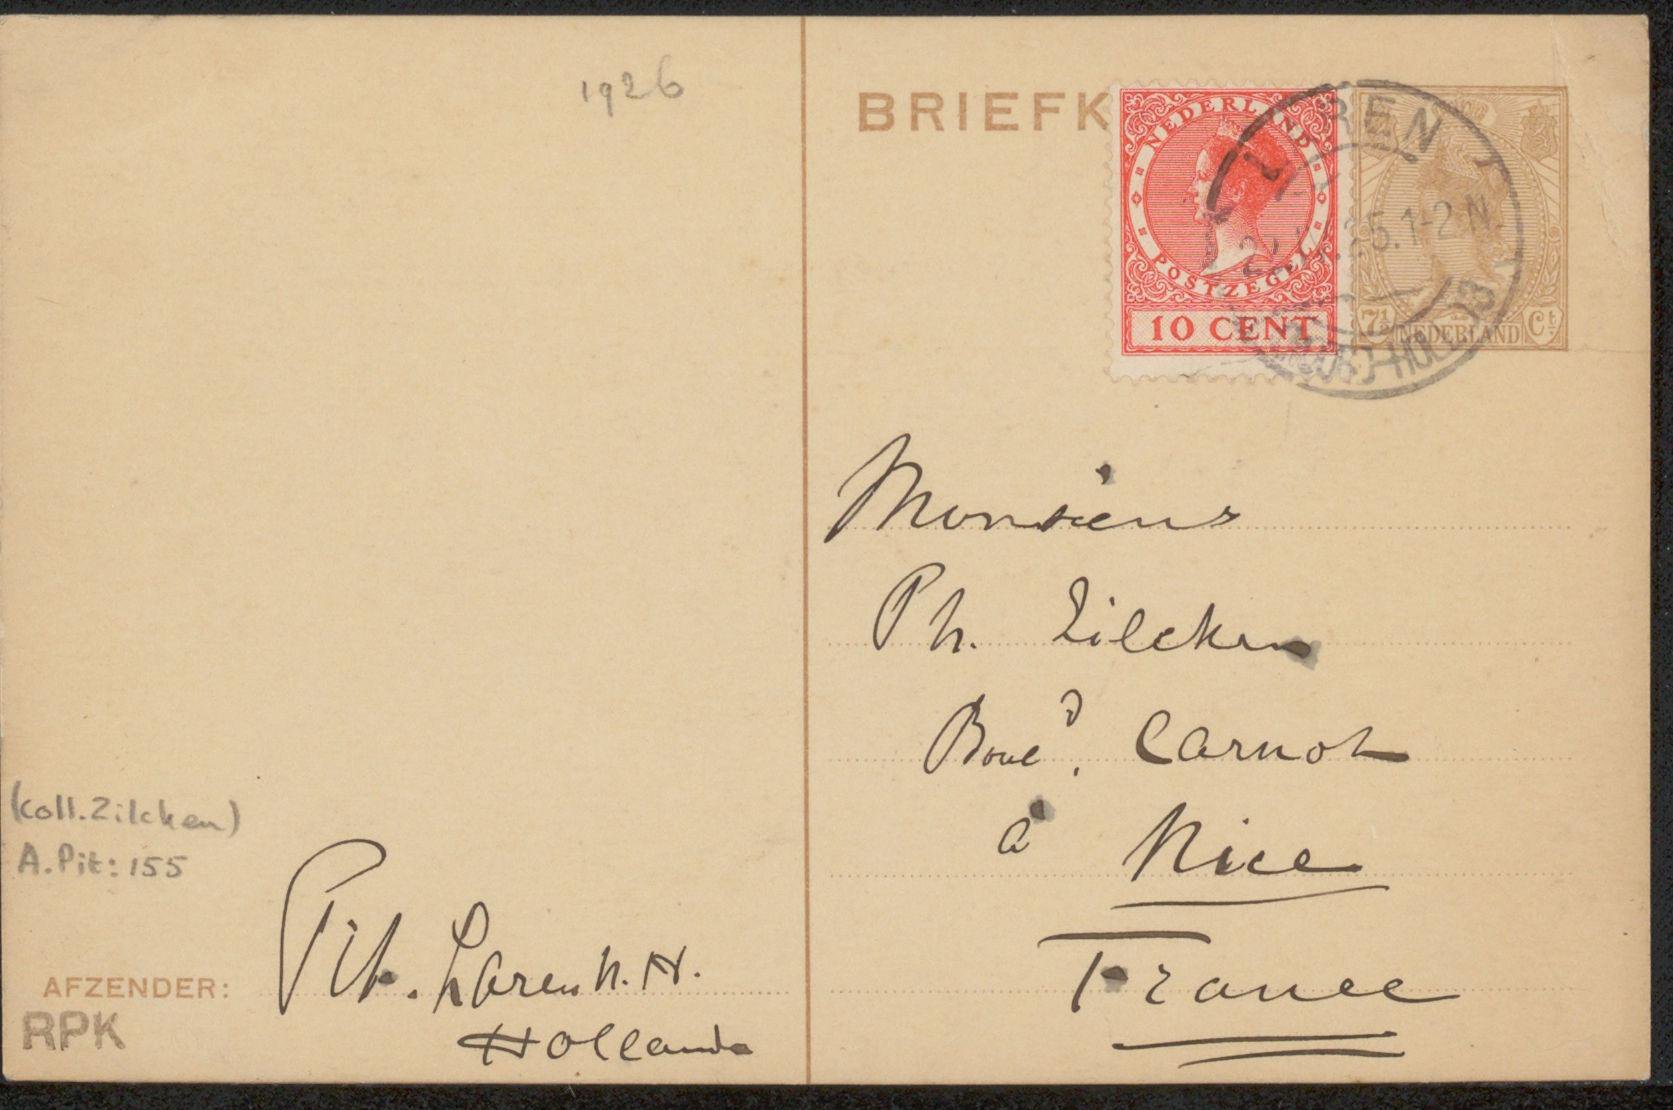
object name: postcard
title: Briefkaart aan Philip Zilcken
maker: adriaan pit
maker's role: print maker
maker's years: 1860-1944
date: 1925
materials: cardboard, ink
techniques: pen, writing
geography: laren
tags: abraham bredius, painter, draughtsman, philip zilcken, painting (including book-illumination, miniature-painting), diseases, printed matter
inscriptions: collector's mark: ‘RPK’